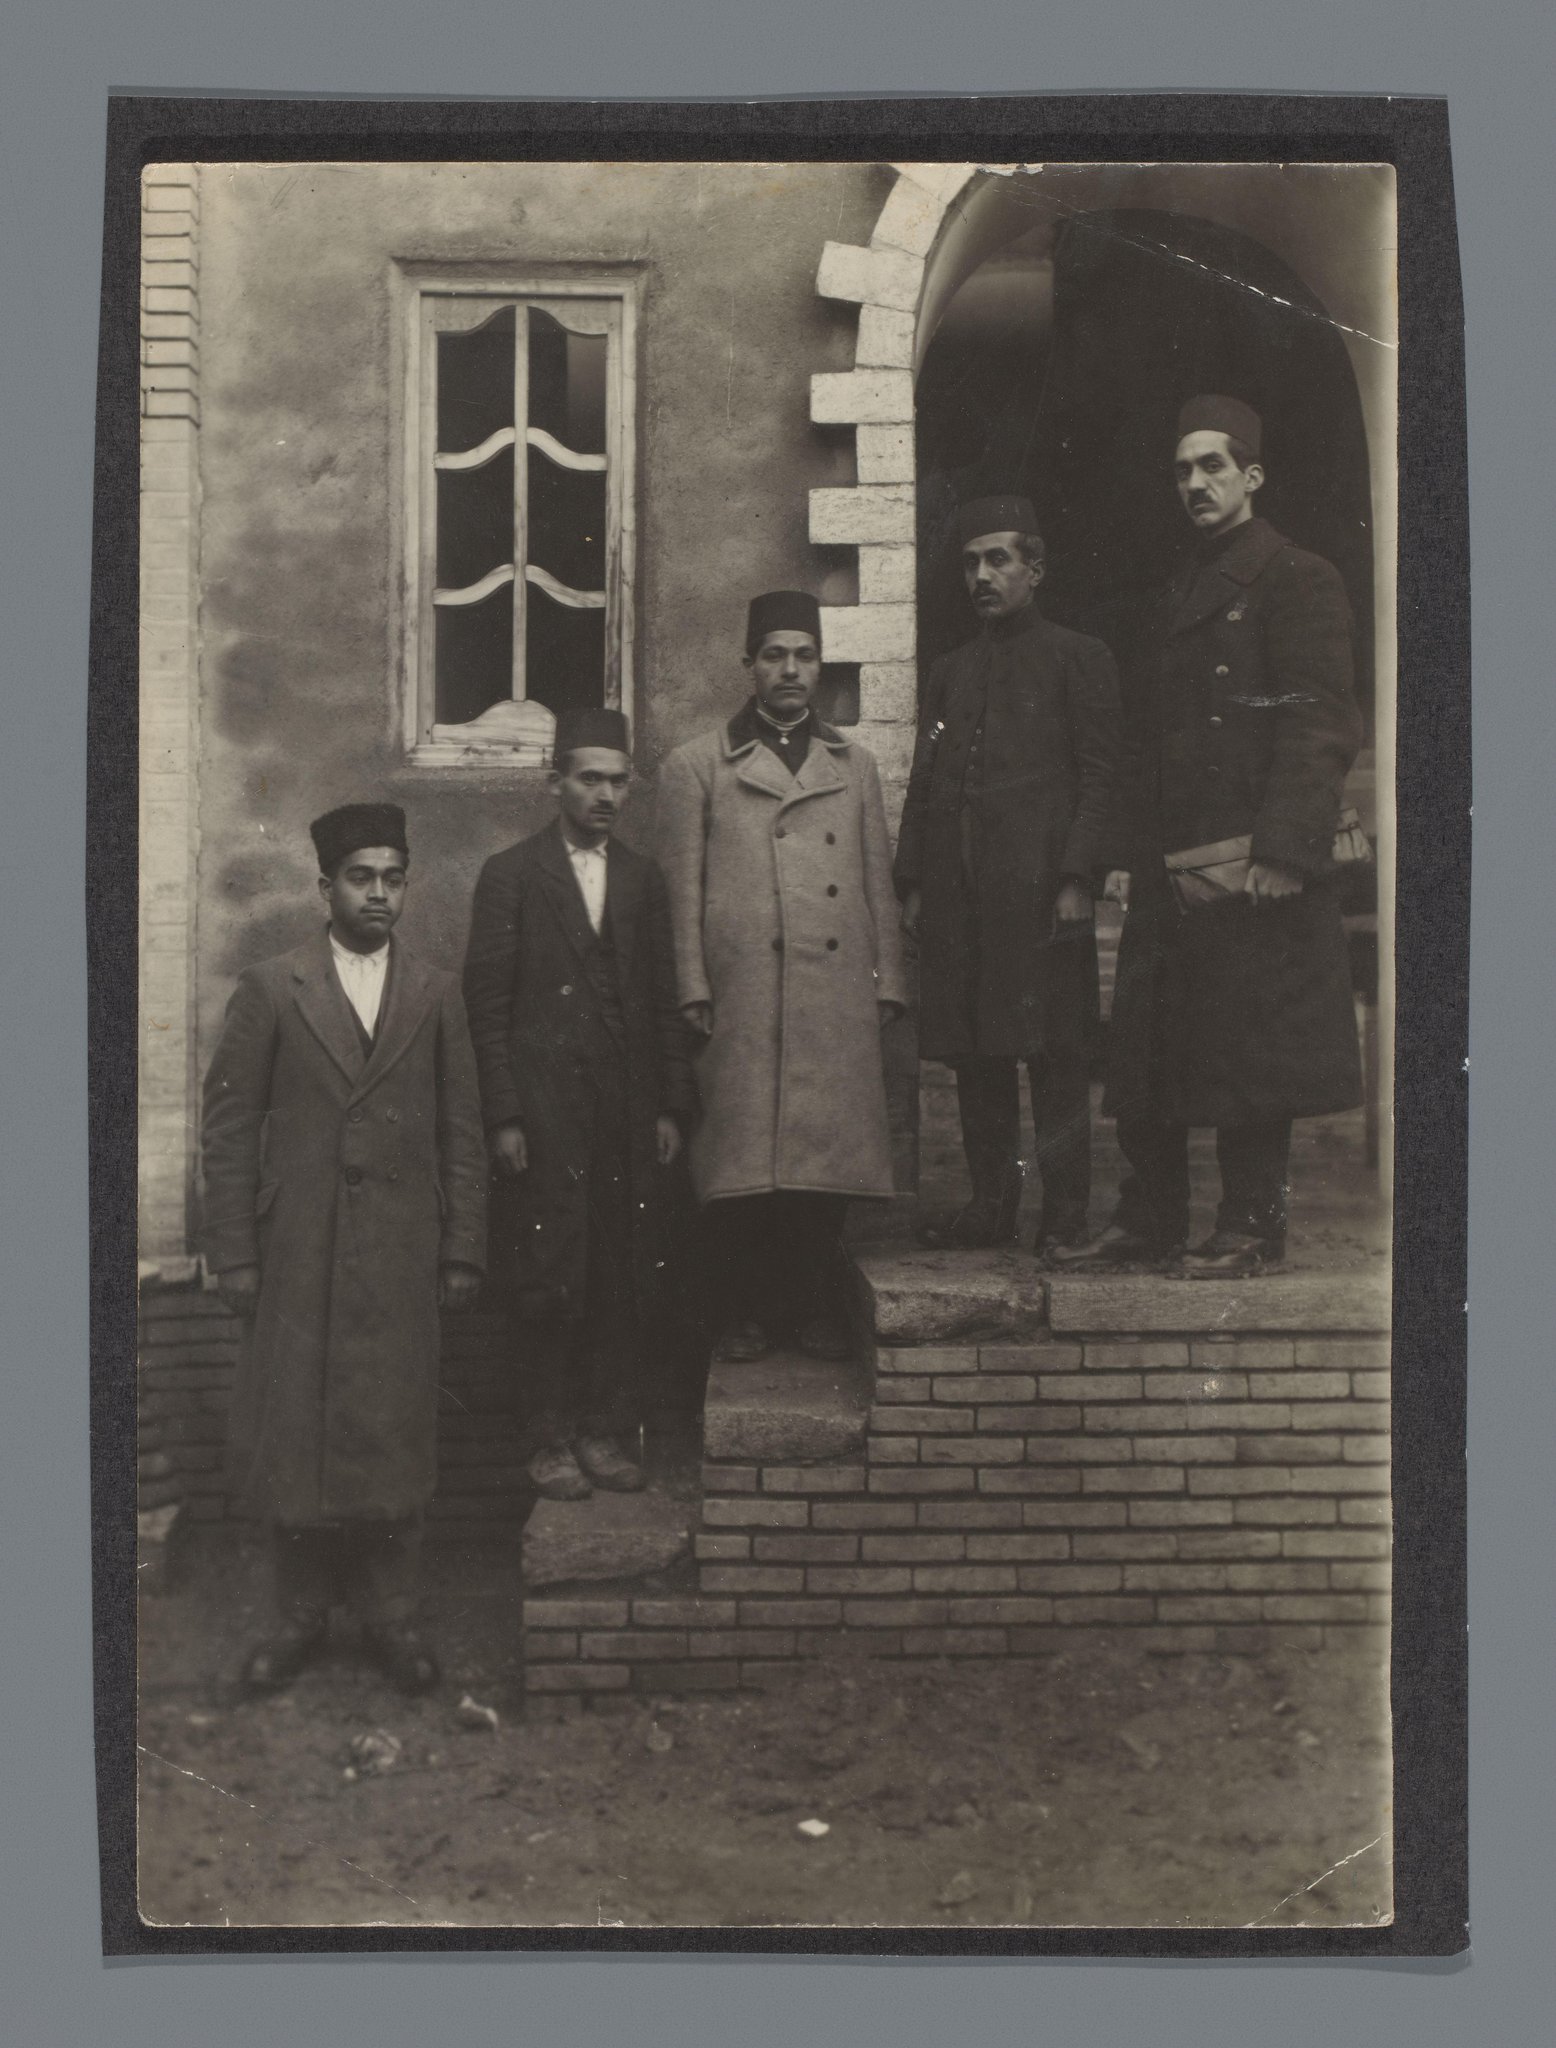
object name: photograph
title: 5 mannen , Tavakoli (uiterst rechts) met portefeuille op de trap voor een gebouw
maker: Anonymous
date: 1912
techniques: gelatin silver print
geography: iran